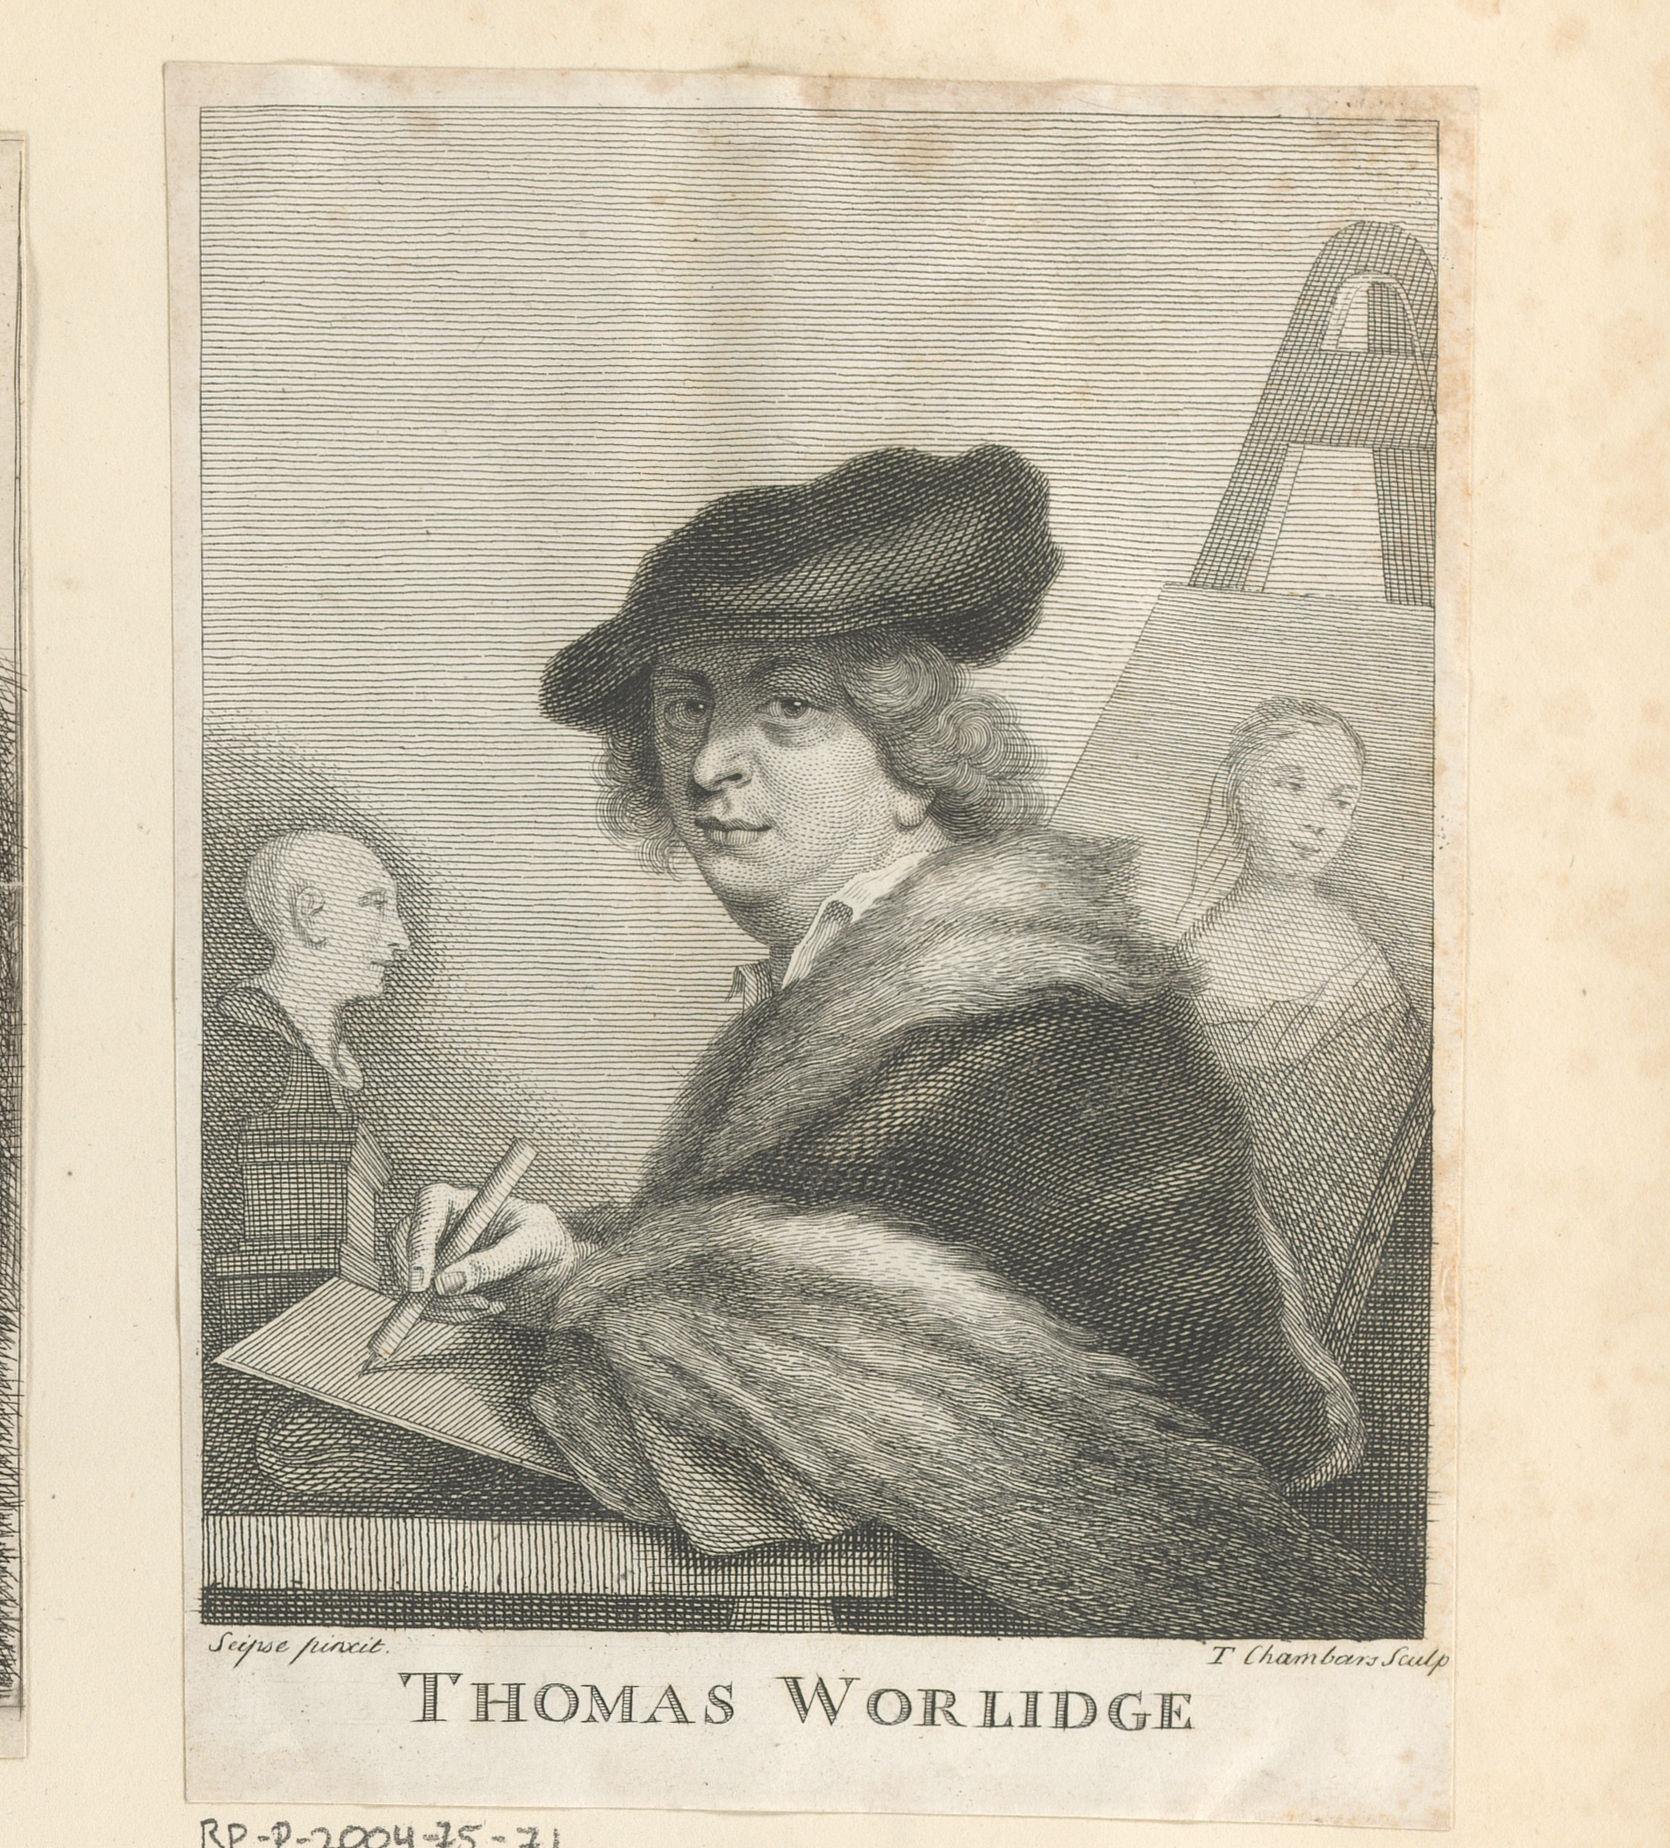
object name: print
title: Portret van Thomas Worlidge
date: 1762-1789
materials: paper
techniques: engraving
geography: london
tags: print maker, thomas worlidge, historical persons, portrait, self-portrait of painter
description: Een eerdere staat van de prent is als titelprent gebruikt voor een gebundelde versie van Worlidges serie A Select Collection of Drawings from Curious Antique Gems. Worlidge maakte al prenten voor deze serie vanaf 1754. Na zijn dood werden de prenten gebundeld in: Worlidge, Thomas. A Select Collection of Drawings from Curious Antique Gems (...). Londen: M. Worlidge, 1768. Prent uit: Walpole, Horace. Anecdotes of painting in England with some account of the principal artists and incidental notes on other arts collected by the late Mr. George Vertue and now digested and published from his original Mss. by Horace Walpole. 4 dln. Londen: Horace Walpole, 1762-1789, dl. 4, p. 66. De samensteller heeft deze prent in het album geplakt als illustratie bij: Pilkington, Matthew en Johann Heinrich Füssli. A dictionary of painters, from the revival of the art to the present period. 4 dln. Londen: John Crowder, 1805, dl. 4, p. 654.